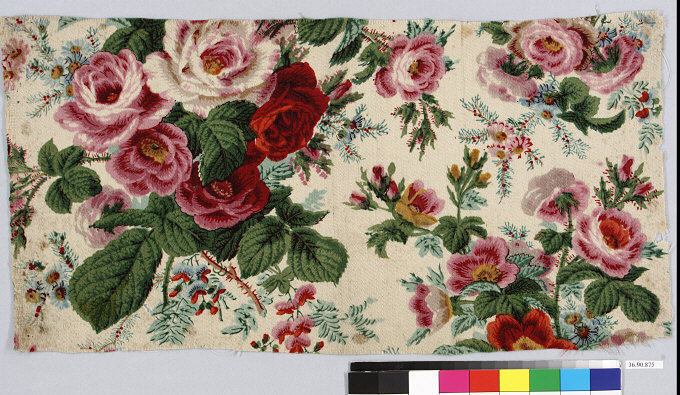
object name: piece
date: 1801-1900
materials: wool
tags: roses,leaves